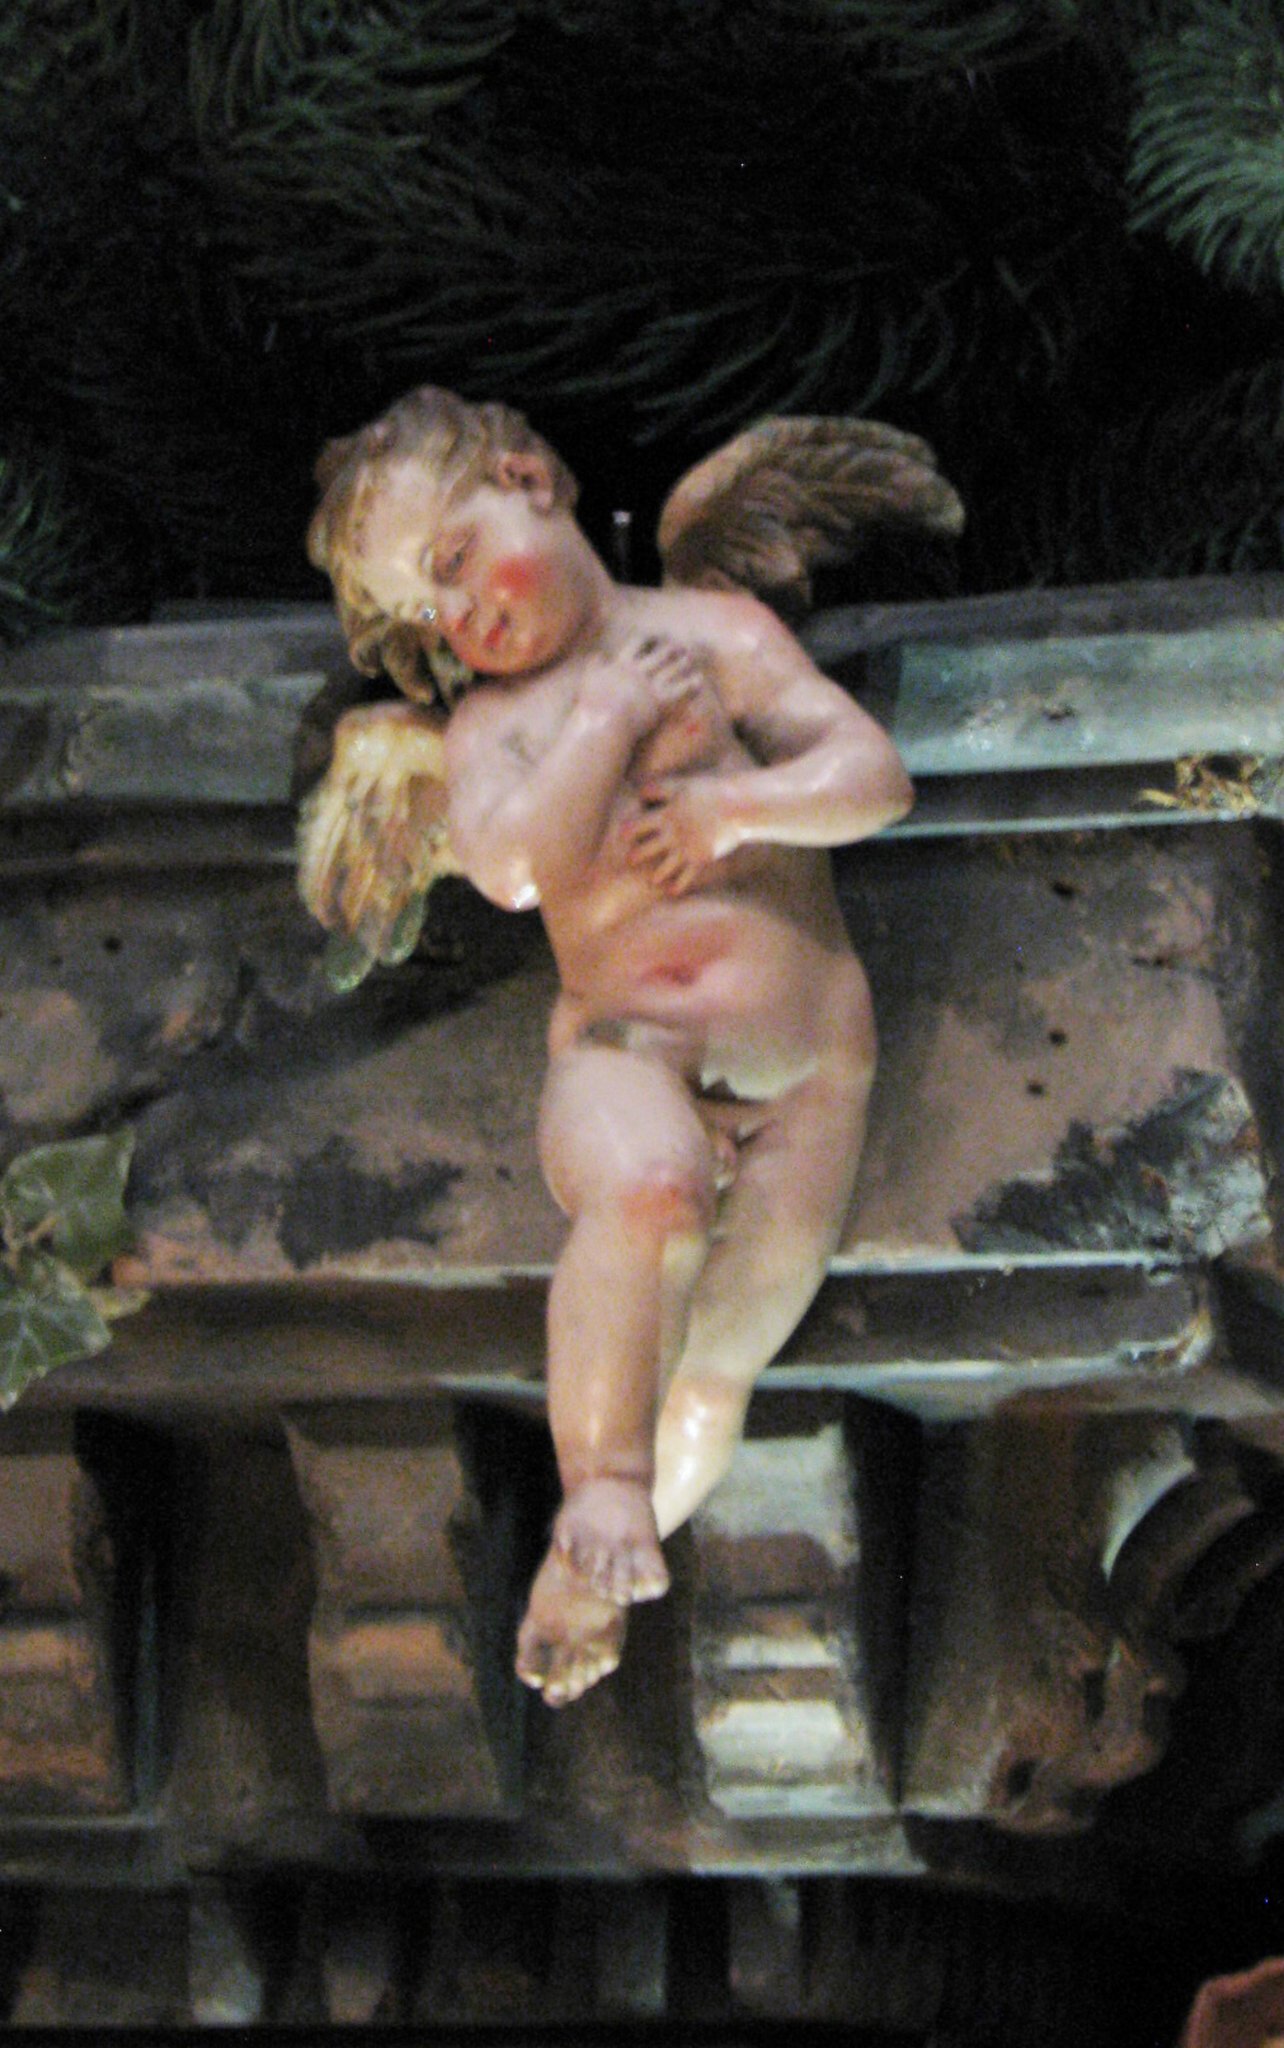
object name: crèche figure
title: Cherub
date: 1751-1800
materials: terracotta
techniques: polychrome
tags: angels